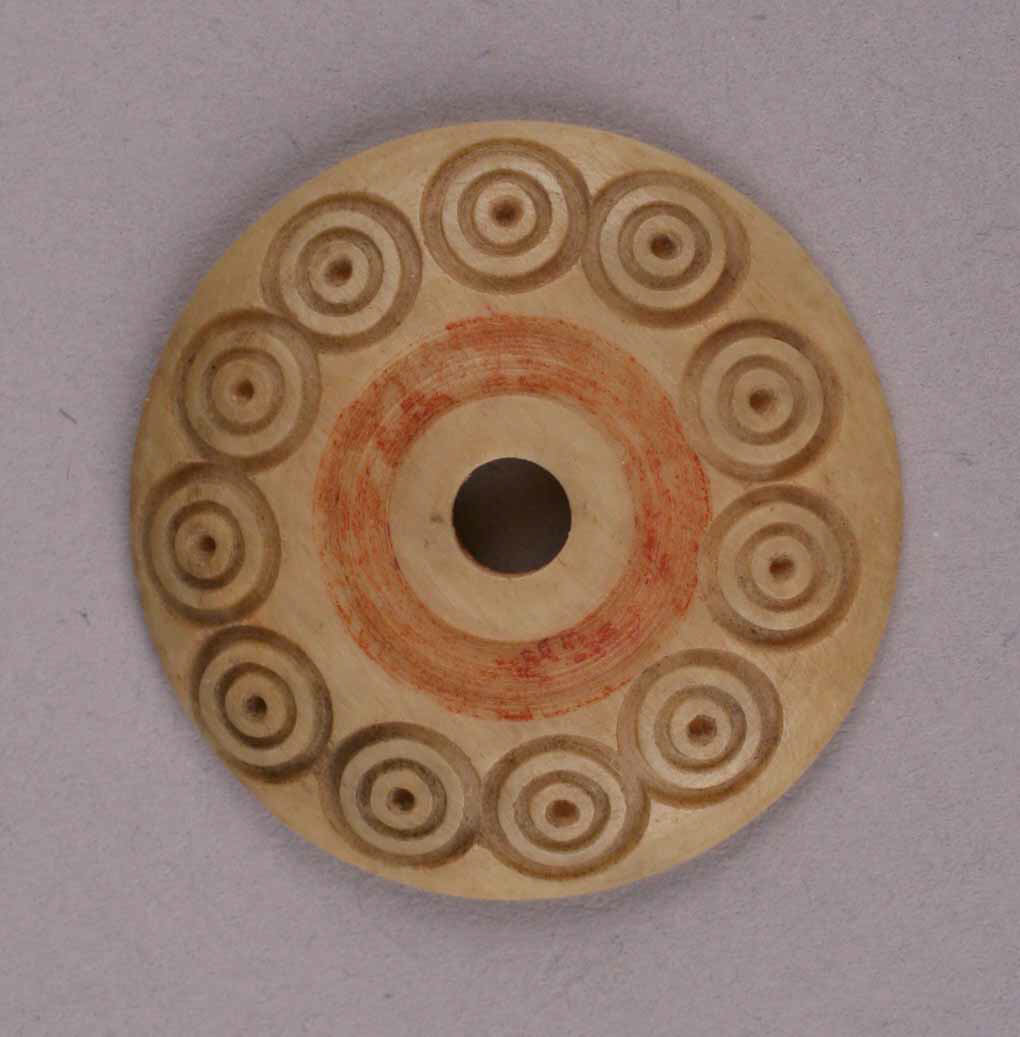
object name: button or bead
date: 801-1000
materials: bone, paint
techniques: incising, inlay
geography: iran